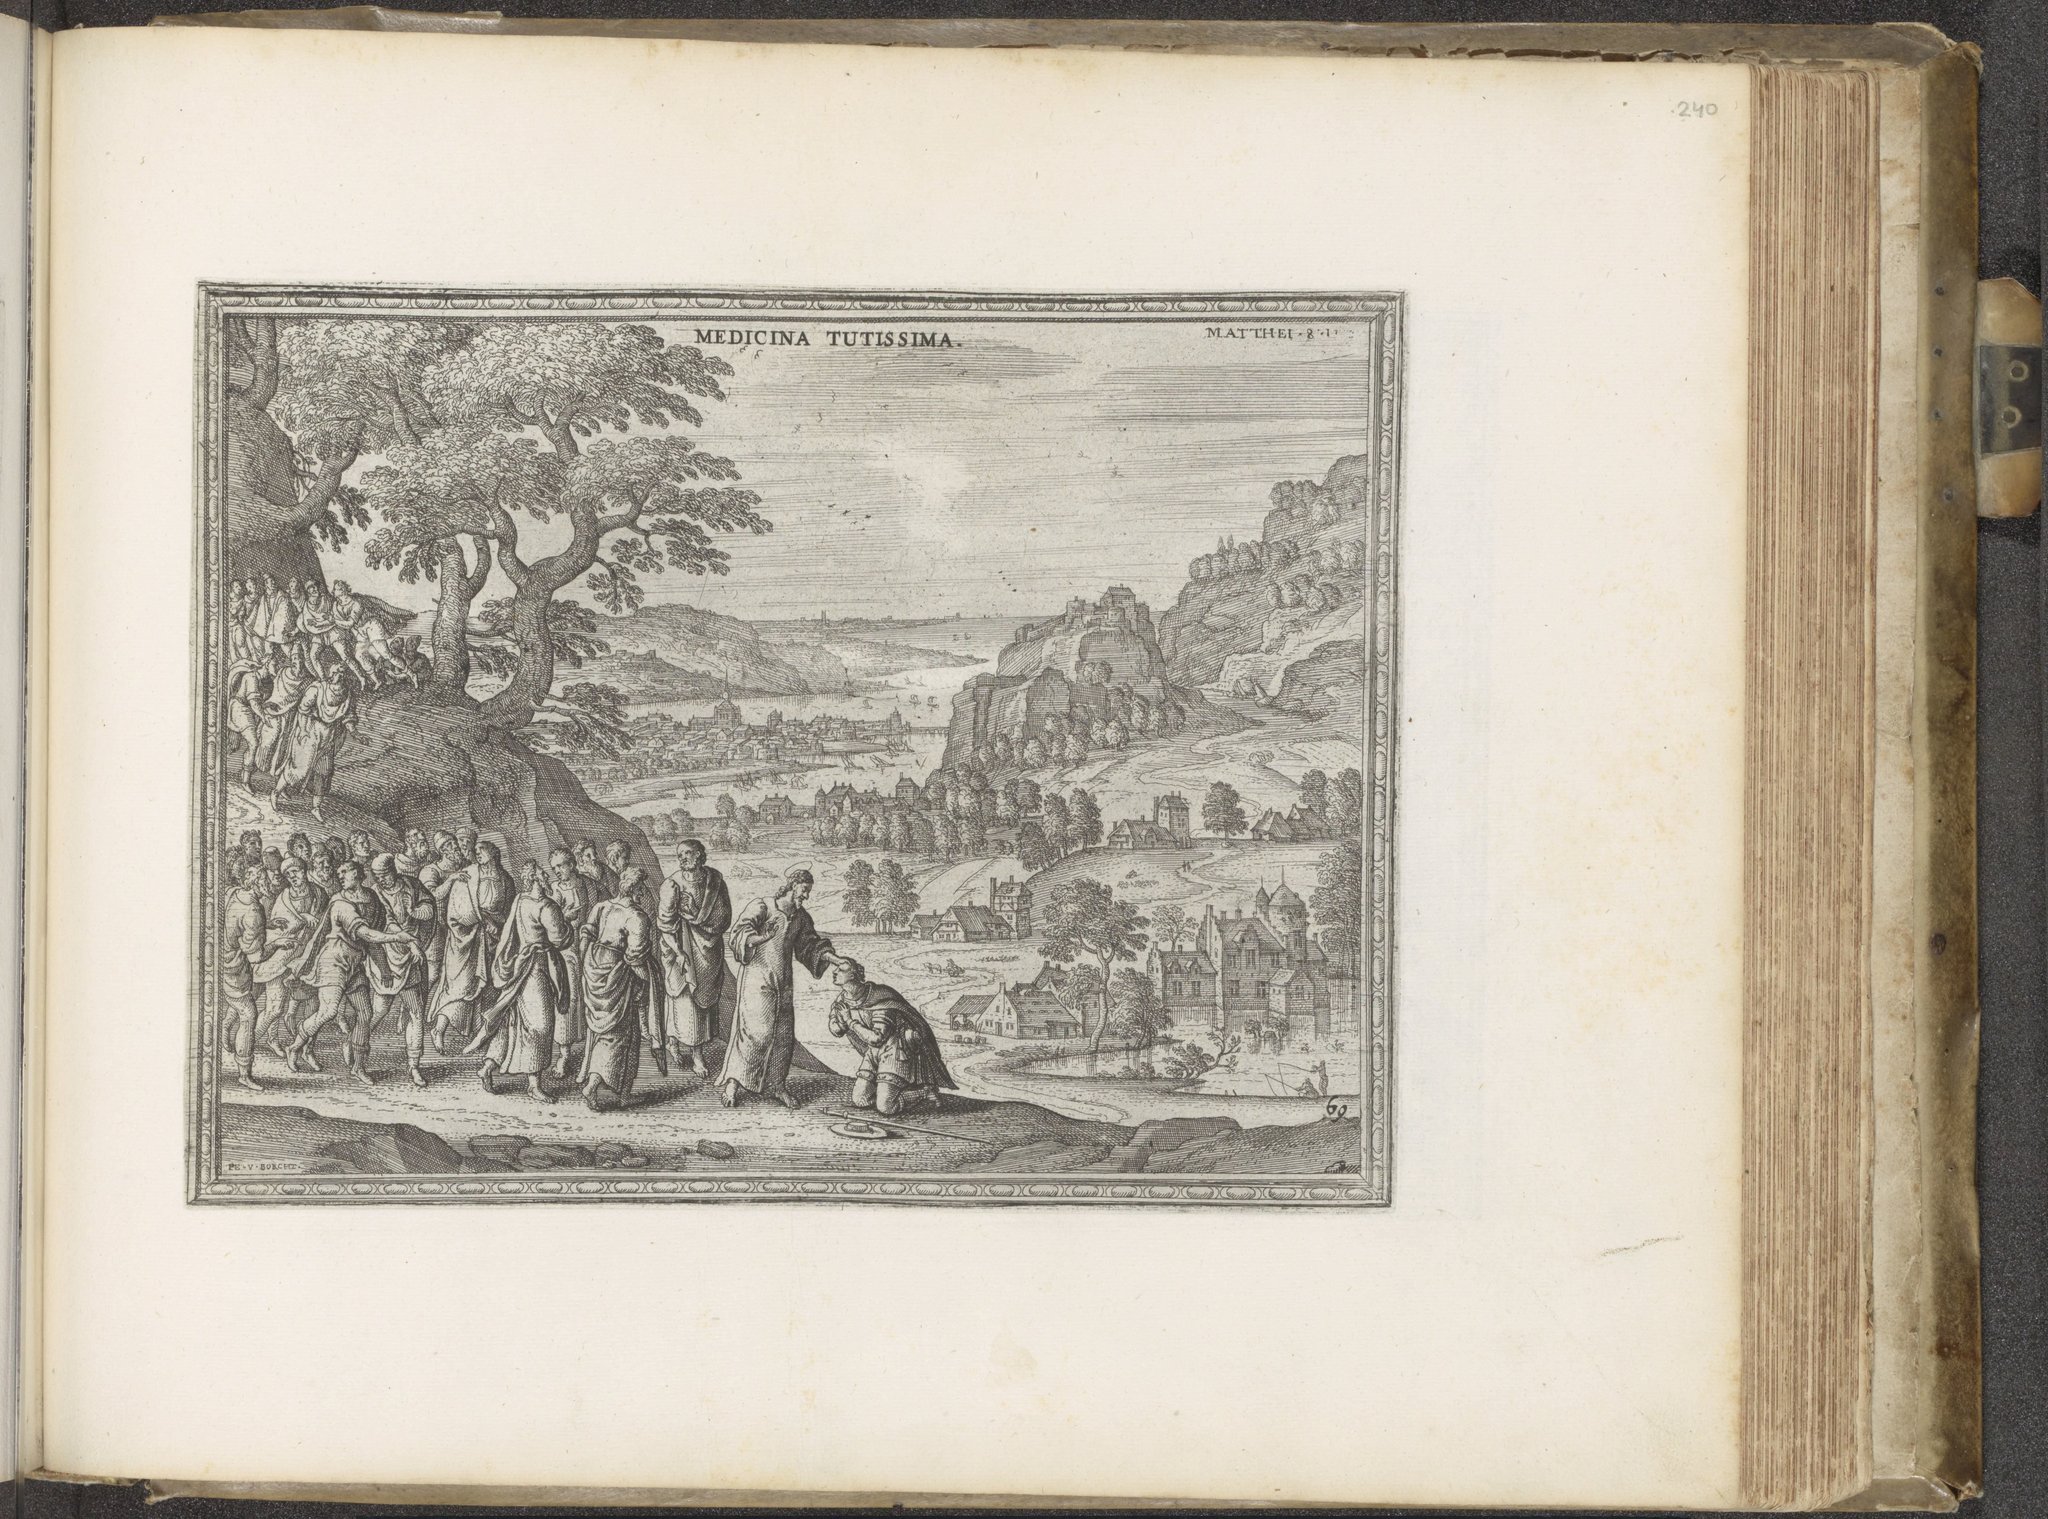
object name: album leaf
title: Den Grooten Emblemata Sacra, bestaande in meer dan vier hondert bybelsche figuren, zoo des Ouden als des Nieuwen Testaments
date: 1582-1593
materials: paper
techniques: etching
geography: amsterdam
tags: city-view, and landscape with man-made constructions, river, healing of one leper, who kneels before christ (matthew 8:1-4; mark 1:40-45; luke 5:12-16)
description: Landschap met een riviermonding. Links een lepralijder op zijn knieën voor Christus biddend om genezing. Christus legt zijn hand op het hoofd van de man en geneest hem. Achter Christus zijn apostelen en andere toeschouwers (Mat. 8:1). De prent maakt deel uit van een album.